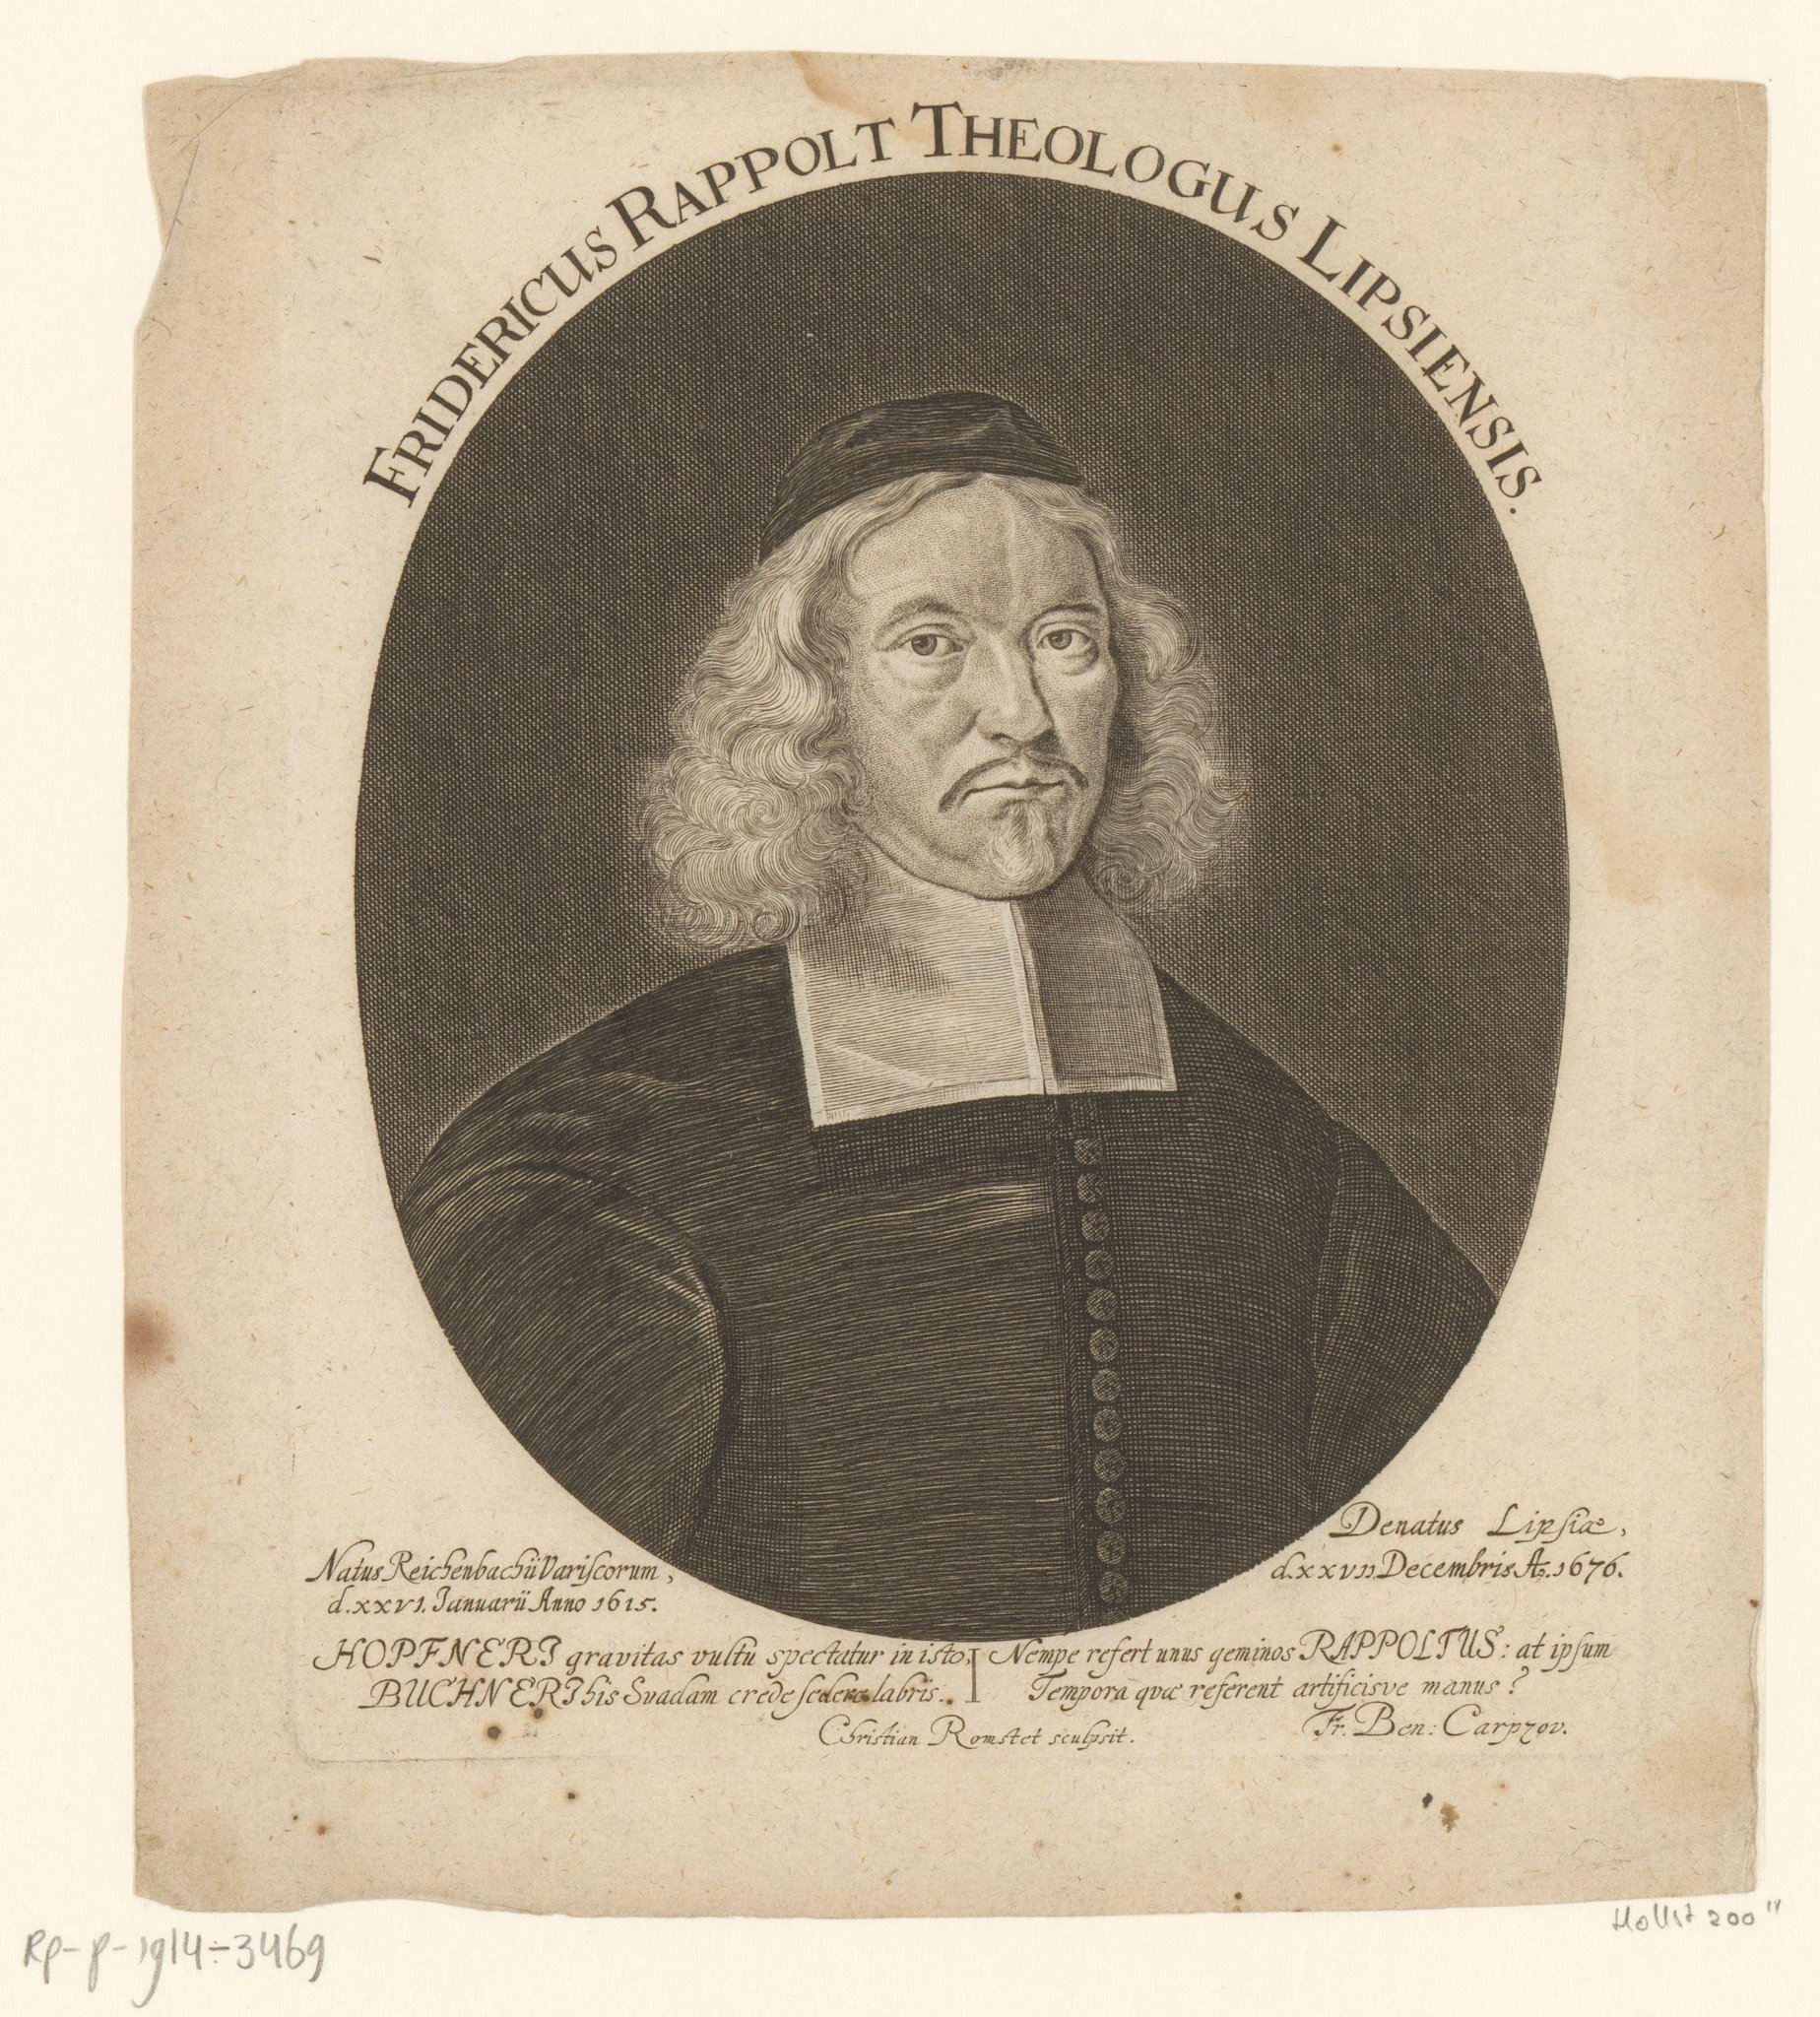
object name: print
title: Portret van Friedrich Rappolt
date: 1665-1721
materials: paper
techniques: engraving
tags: friedrich rappolt, theologian, historical persons, portrait of a writer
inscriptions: collector's mark: Lugt 2228